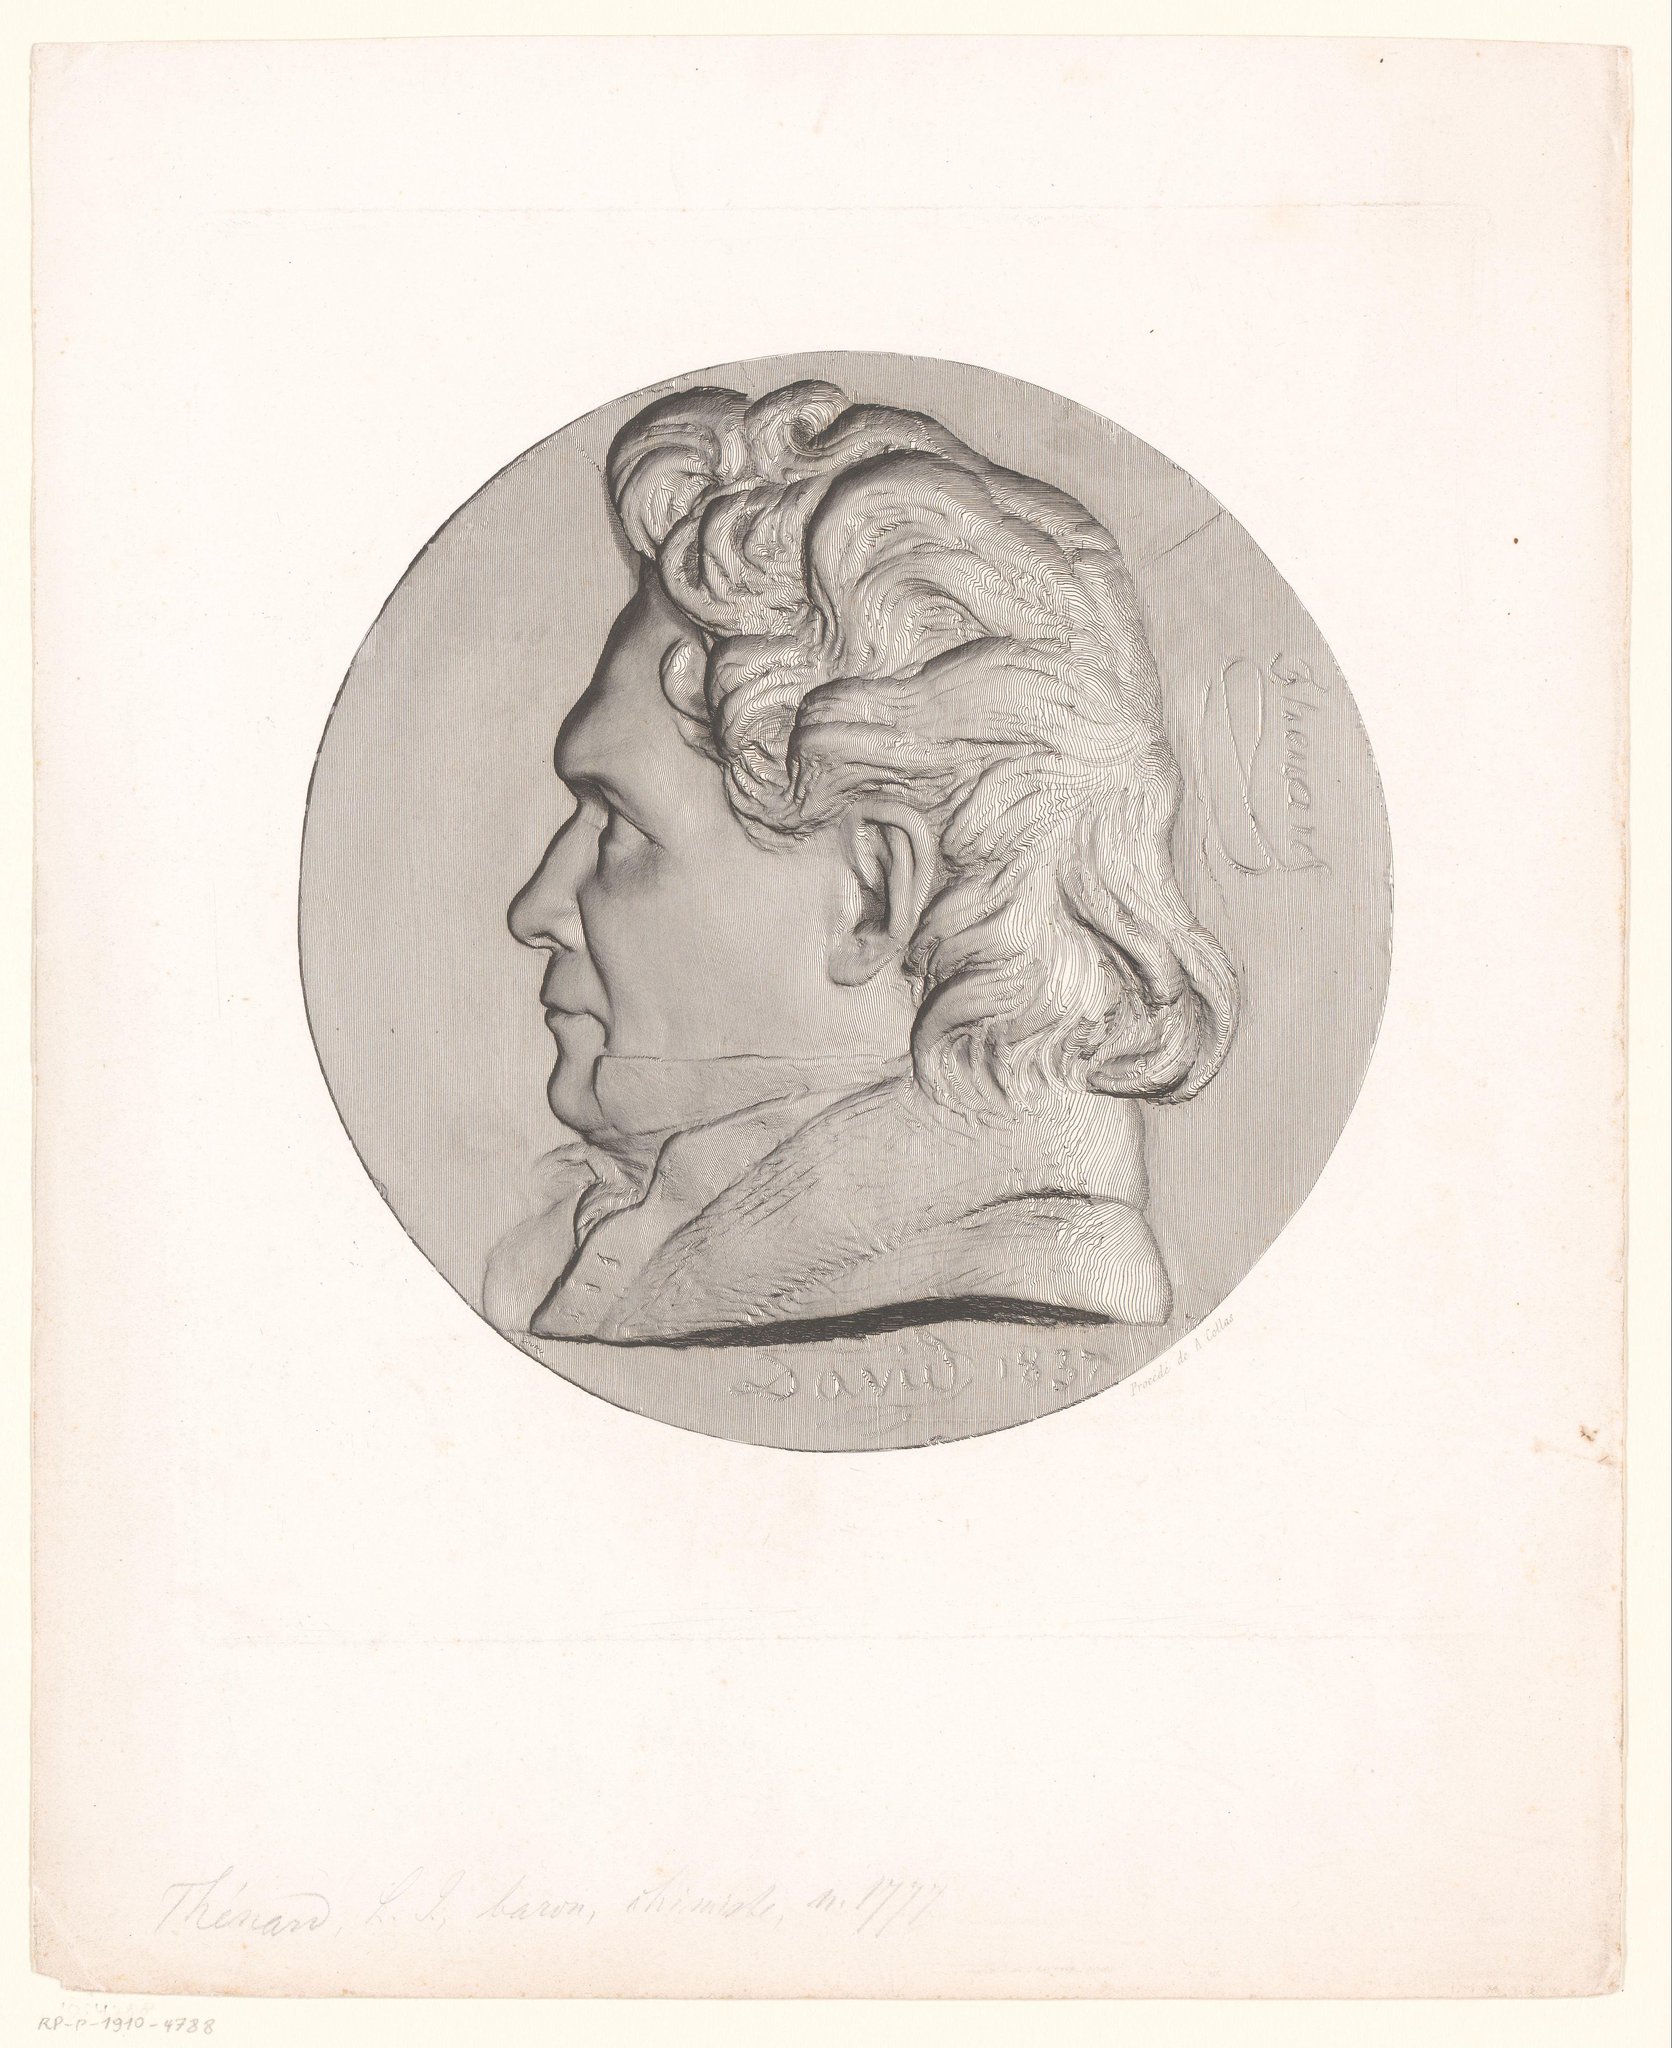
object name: print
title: Serie medaillons met vooraanstaande figuren uit het begin van de negentiende eeuw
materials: paper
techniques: relief engraving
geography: france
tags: ornament ~ medallion, historical persons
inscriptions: collector's mark: Lugt 2228